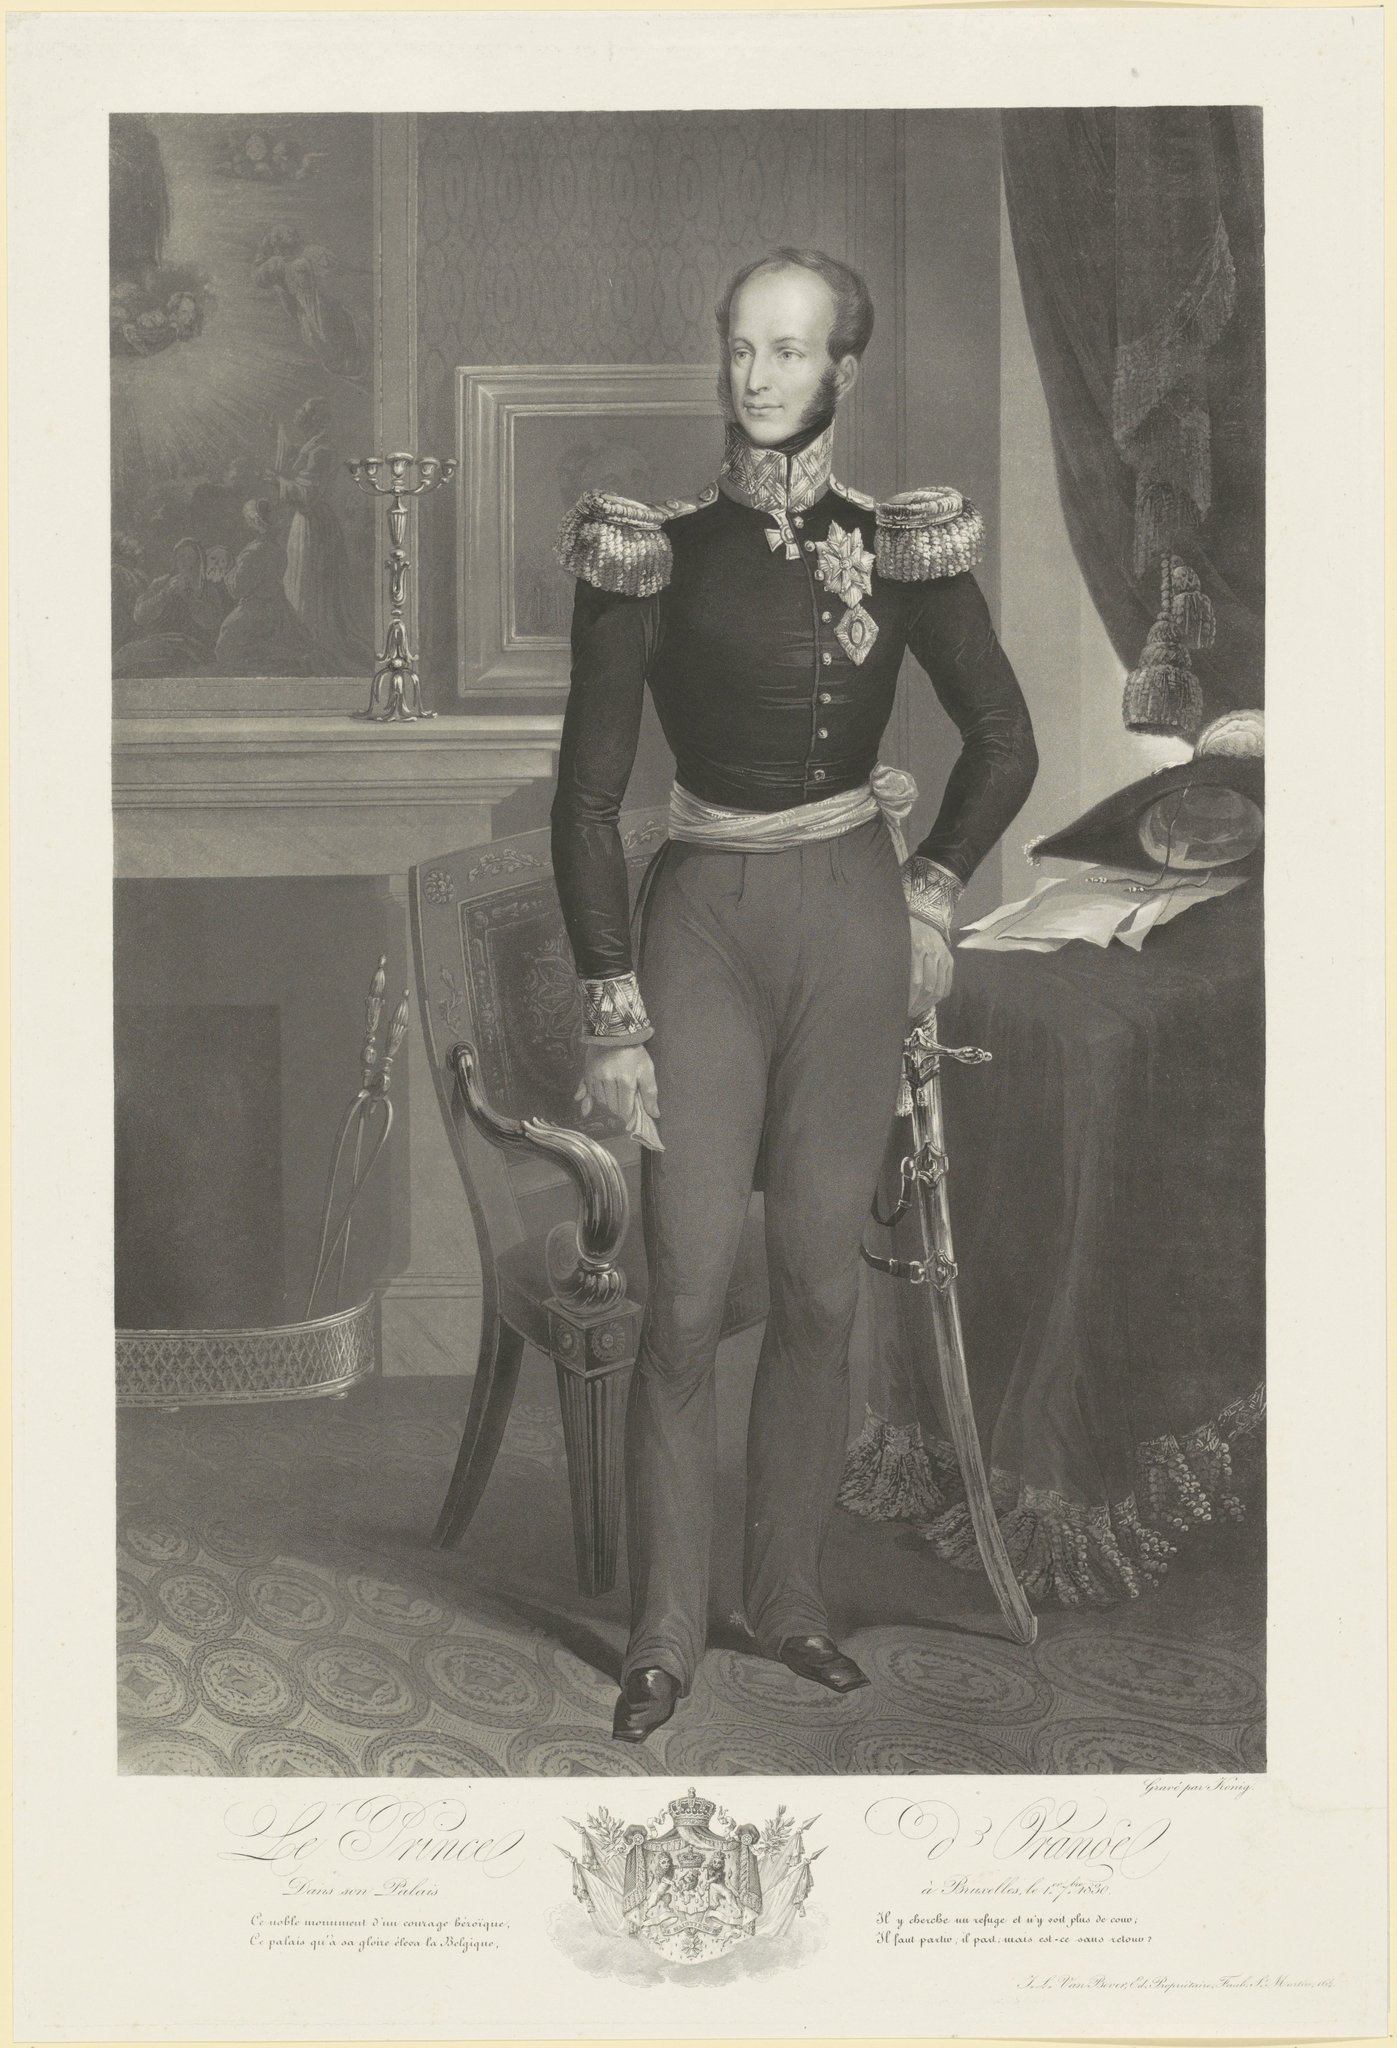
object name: print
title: Portret van Willem II, koning der Nederlanden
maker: könig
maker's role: print maker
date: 1830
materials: paper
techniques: aquatint, etching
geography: paris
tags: the hague, william ii of the netherlands, brussels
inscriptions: date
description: Portret van Willem II in het paleis te Brussel. In zijn rechterhand zijn handschoenen. Midden onder zijn wapen met een kroon en twee leeuwen. Daaronder op een banderol zijn geslachtsspreuk. In de ondermarge zijn titel, een regel Franse tekst en twee kolommen met elk twee regels Franse tekst.